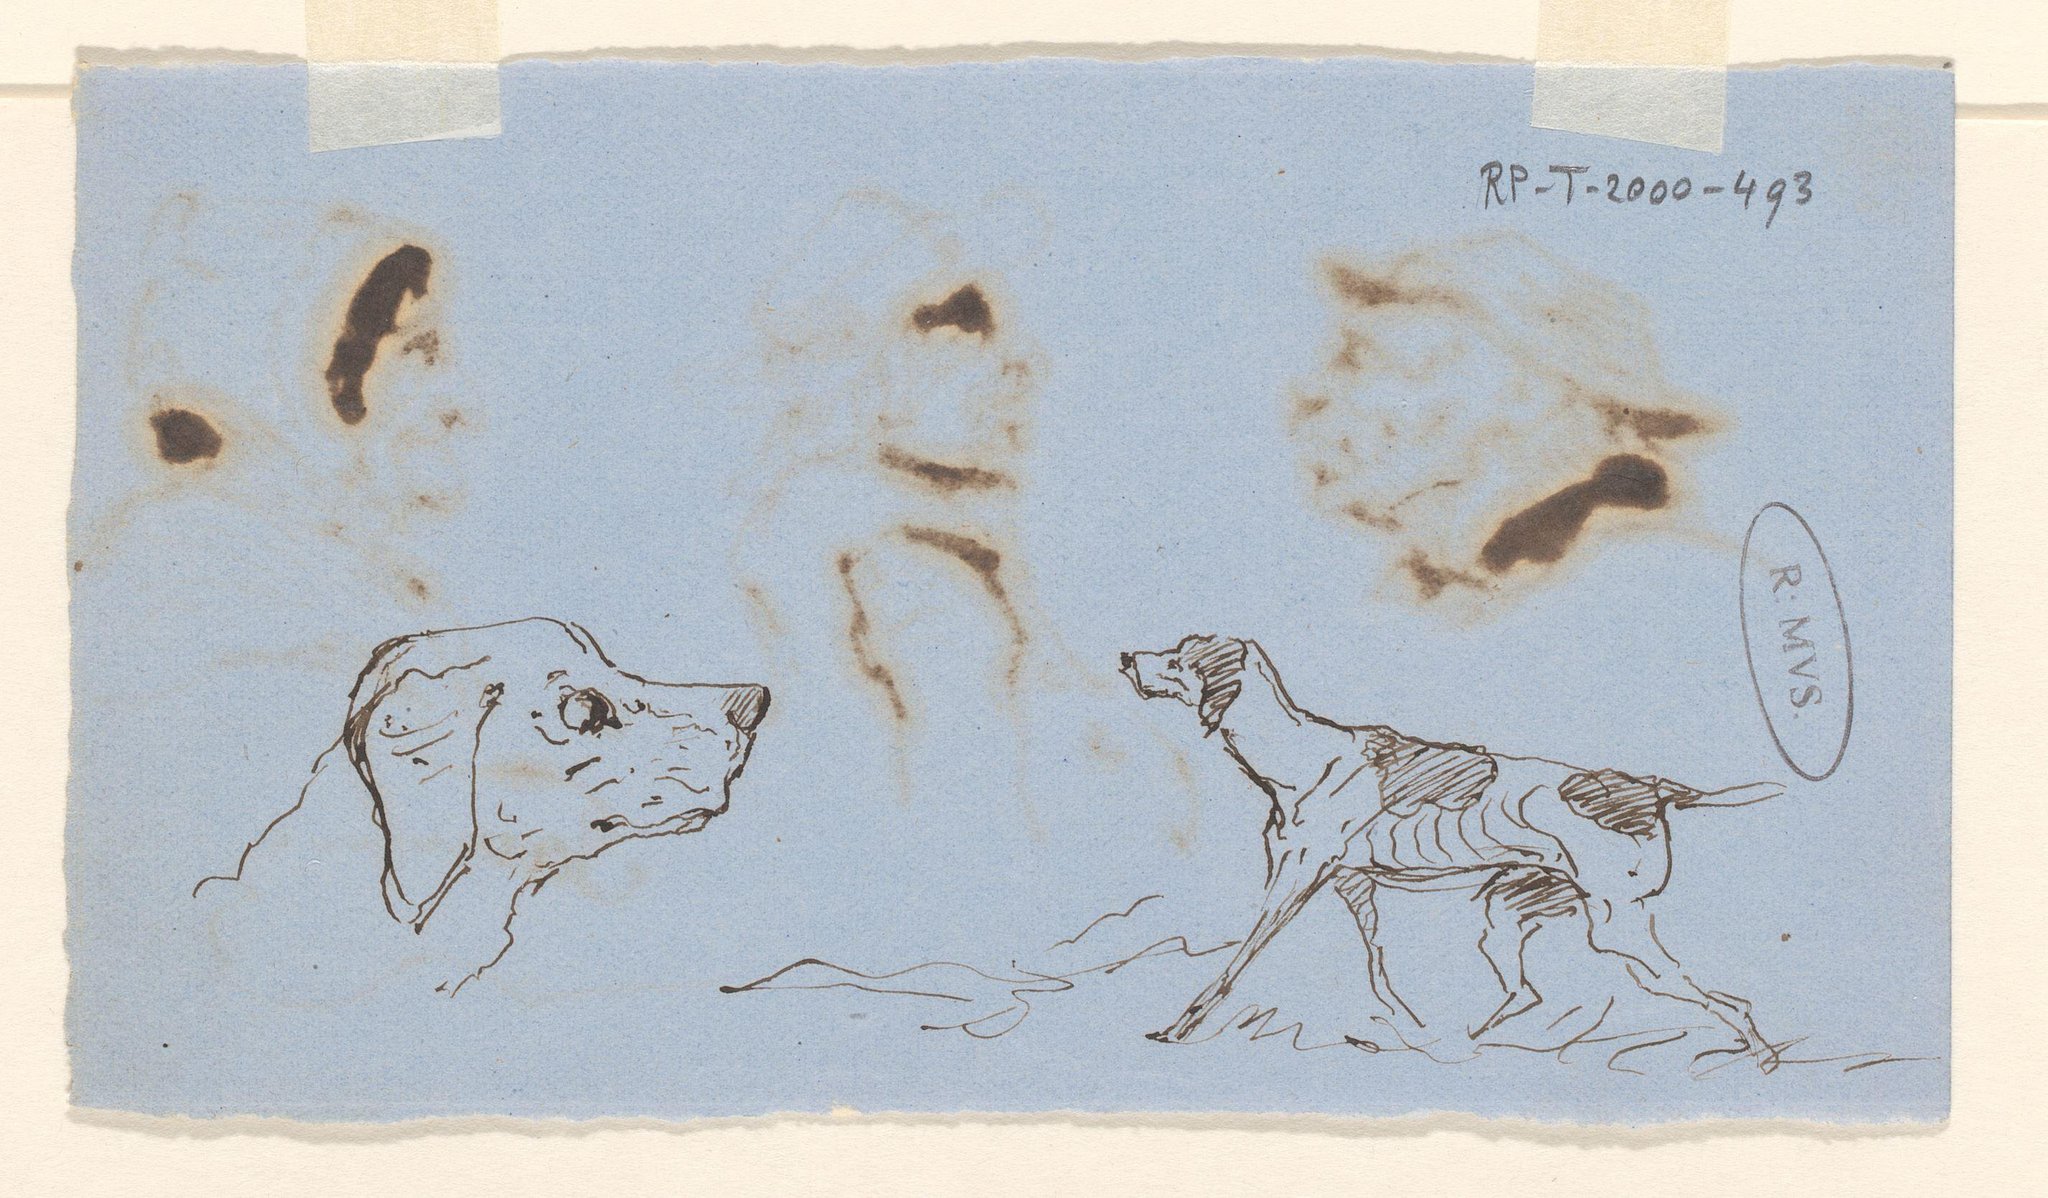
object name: drawing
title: Jachthond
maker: johannes tavenraat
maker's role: draughtsman, painter, print maker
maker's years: 1809-1881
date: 1840-1880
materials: ink, paper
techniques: pen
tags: hunting dogs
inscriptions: collector's mark: Lugt 2228